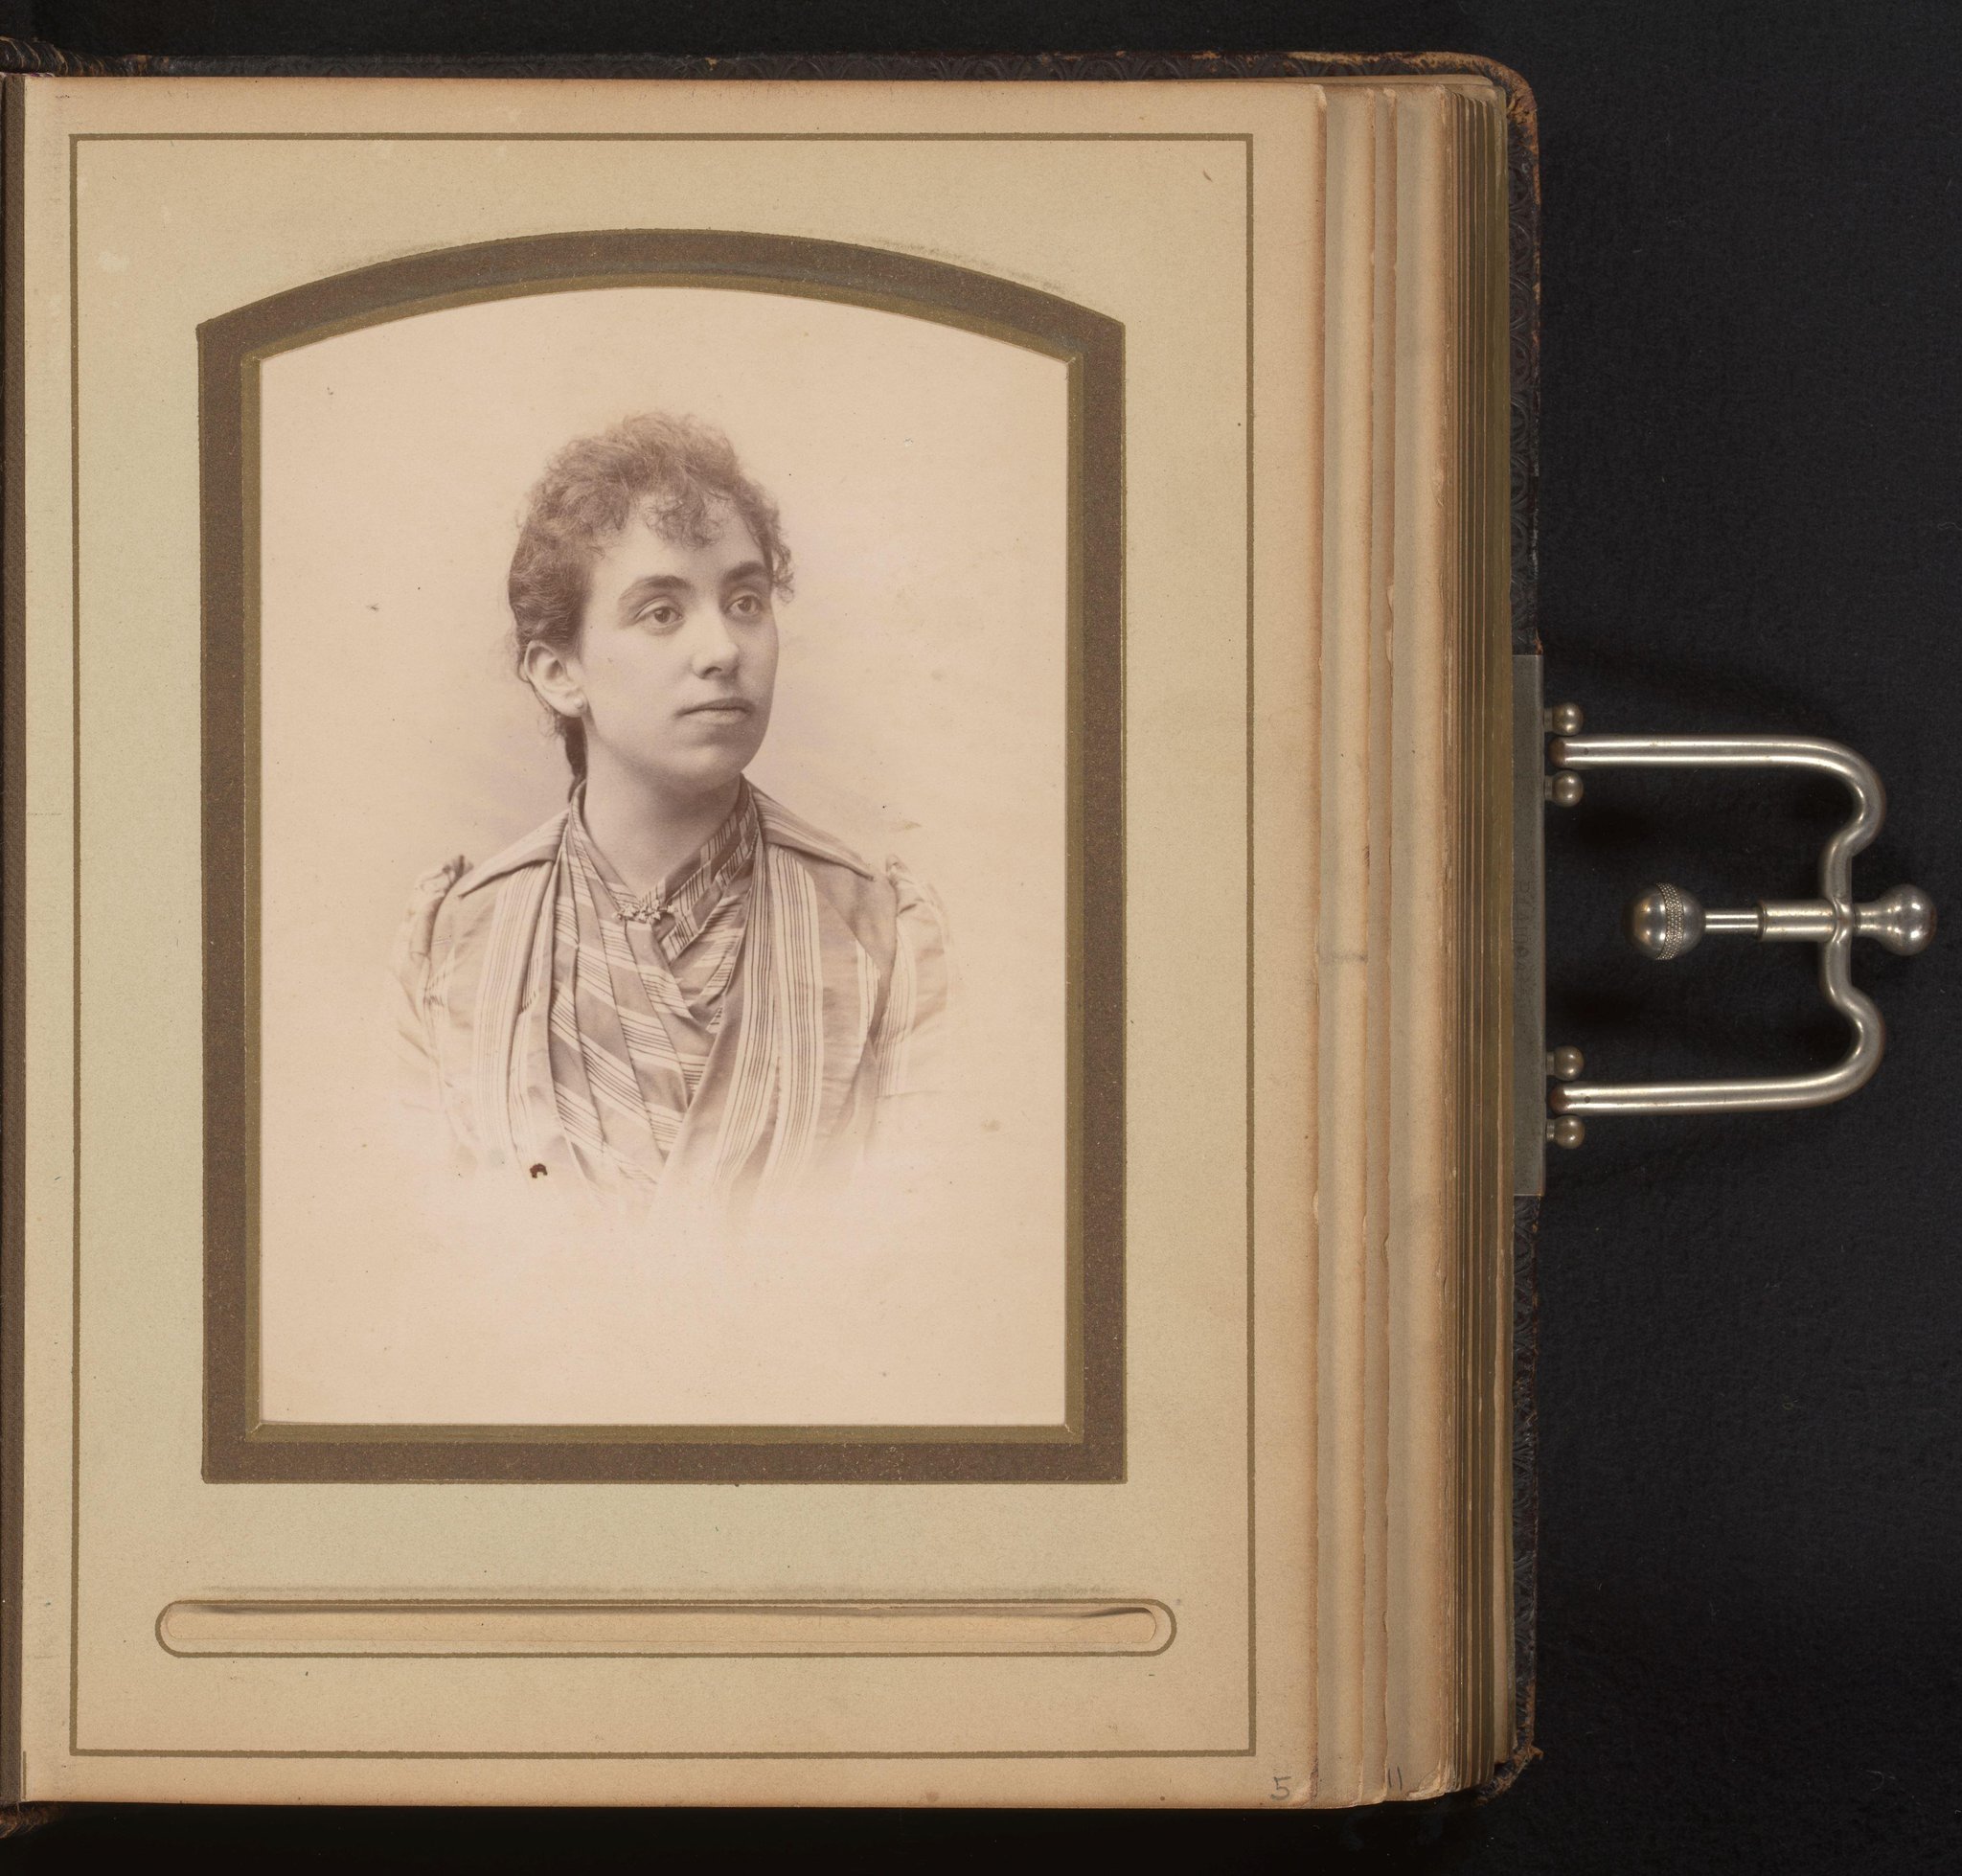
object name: album leaf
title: Portret van een jonge vrouw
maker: léon langlois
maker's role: fotograaf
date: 1880-1940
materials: cardboard, photographic support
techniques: collodion silver print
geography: paris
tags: adolescent, young woman, maiden, historical persons - bb - woman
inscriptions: inscription: ‘Photographie/ de l'Eldorado/ Médaille d'Argent/ L. Langlois/ Bould. de Strasbourg/ No. 7/ Paris’